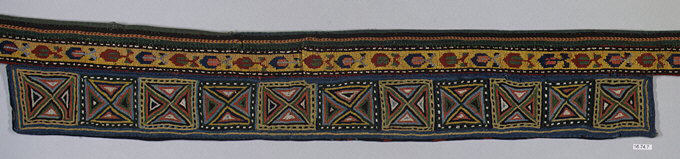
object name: headband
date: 1867-1900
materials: silk, wool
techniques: embroidery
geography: iran